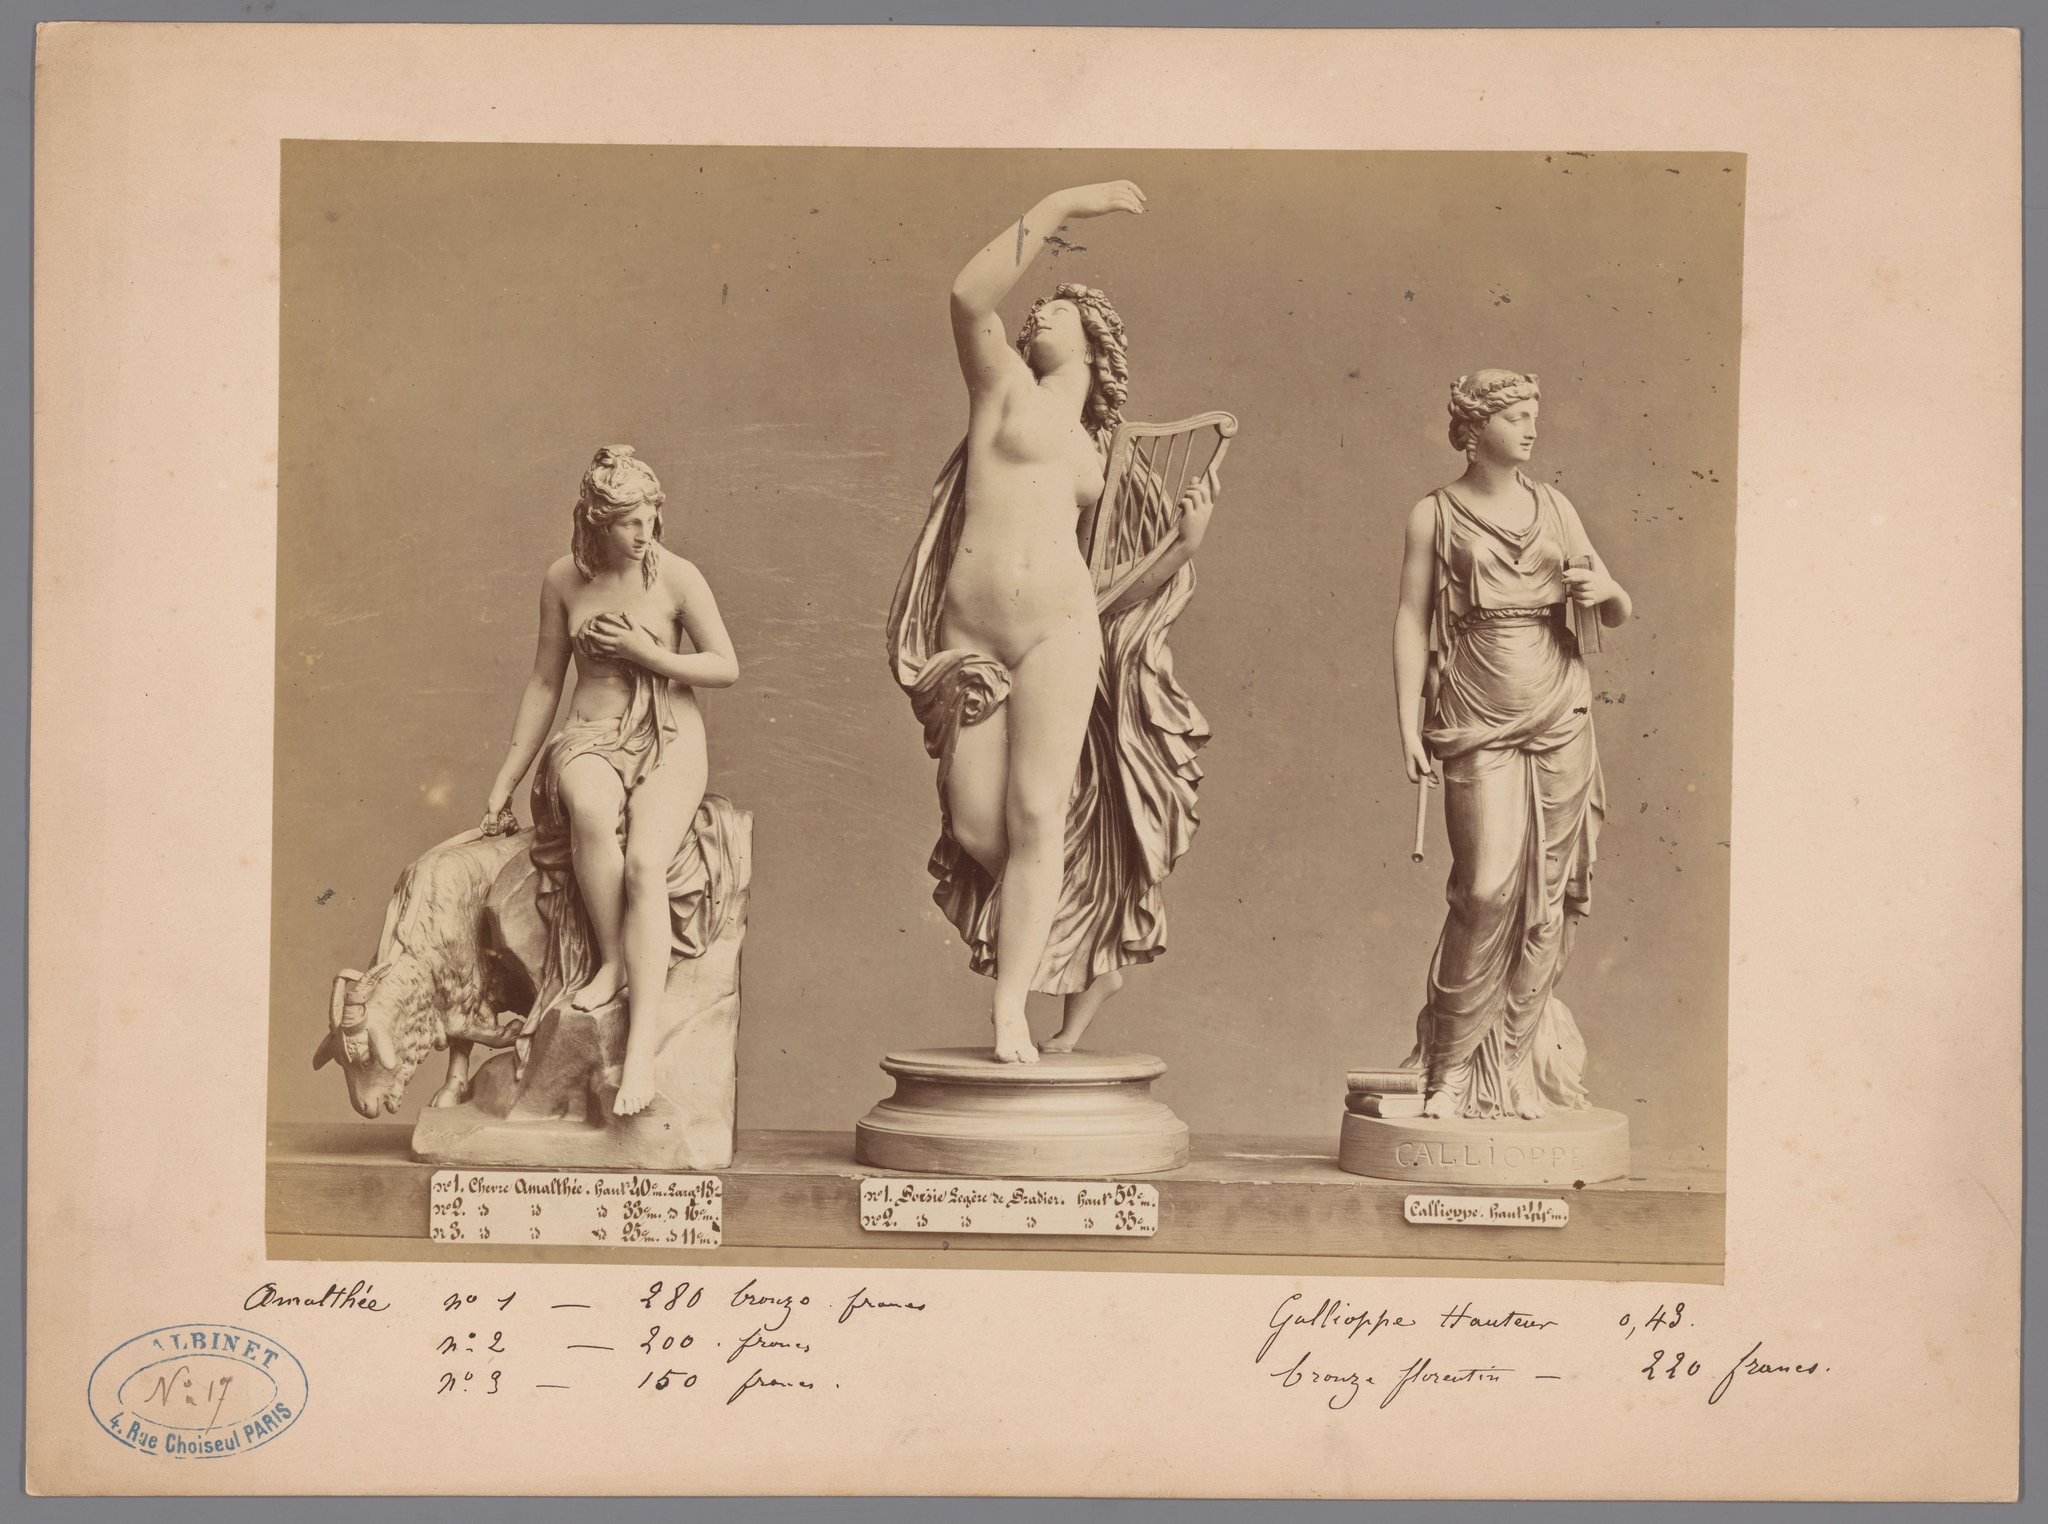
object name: photograph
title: Gezicht op drie beelden of afgietsels van beelden van mythologische figuren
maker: Anonymous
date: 1850-1900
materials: cardboard, photographic support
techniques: albumen print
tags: sculpture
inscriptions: inscription: ‘Gallioppe Hauteur 0,43/ bronze florentin - 220 francs’, inscription: ‘[...]/ Boasberg/ april 84’, number: ‘No. 17’, stamp: ‘Albinet/ 4. Rue Choiseul Paris’, inscription: ‘Amalthée no 1 - 280 [...]/ No 2 - 200 francs/ No 3 -150 francs’